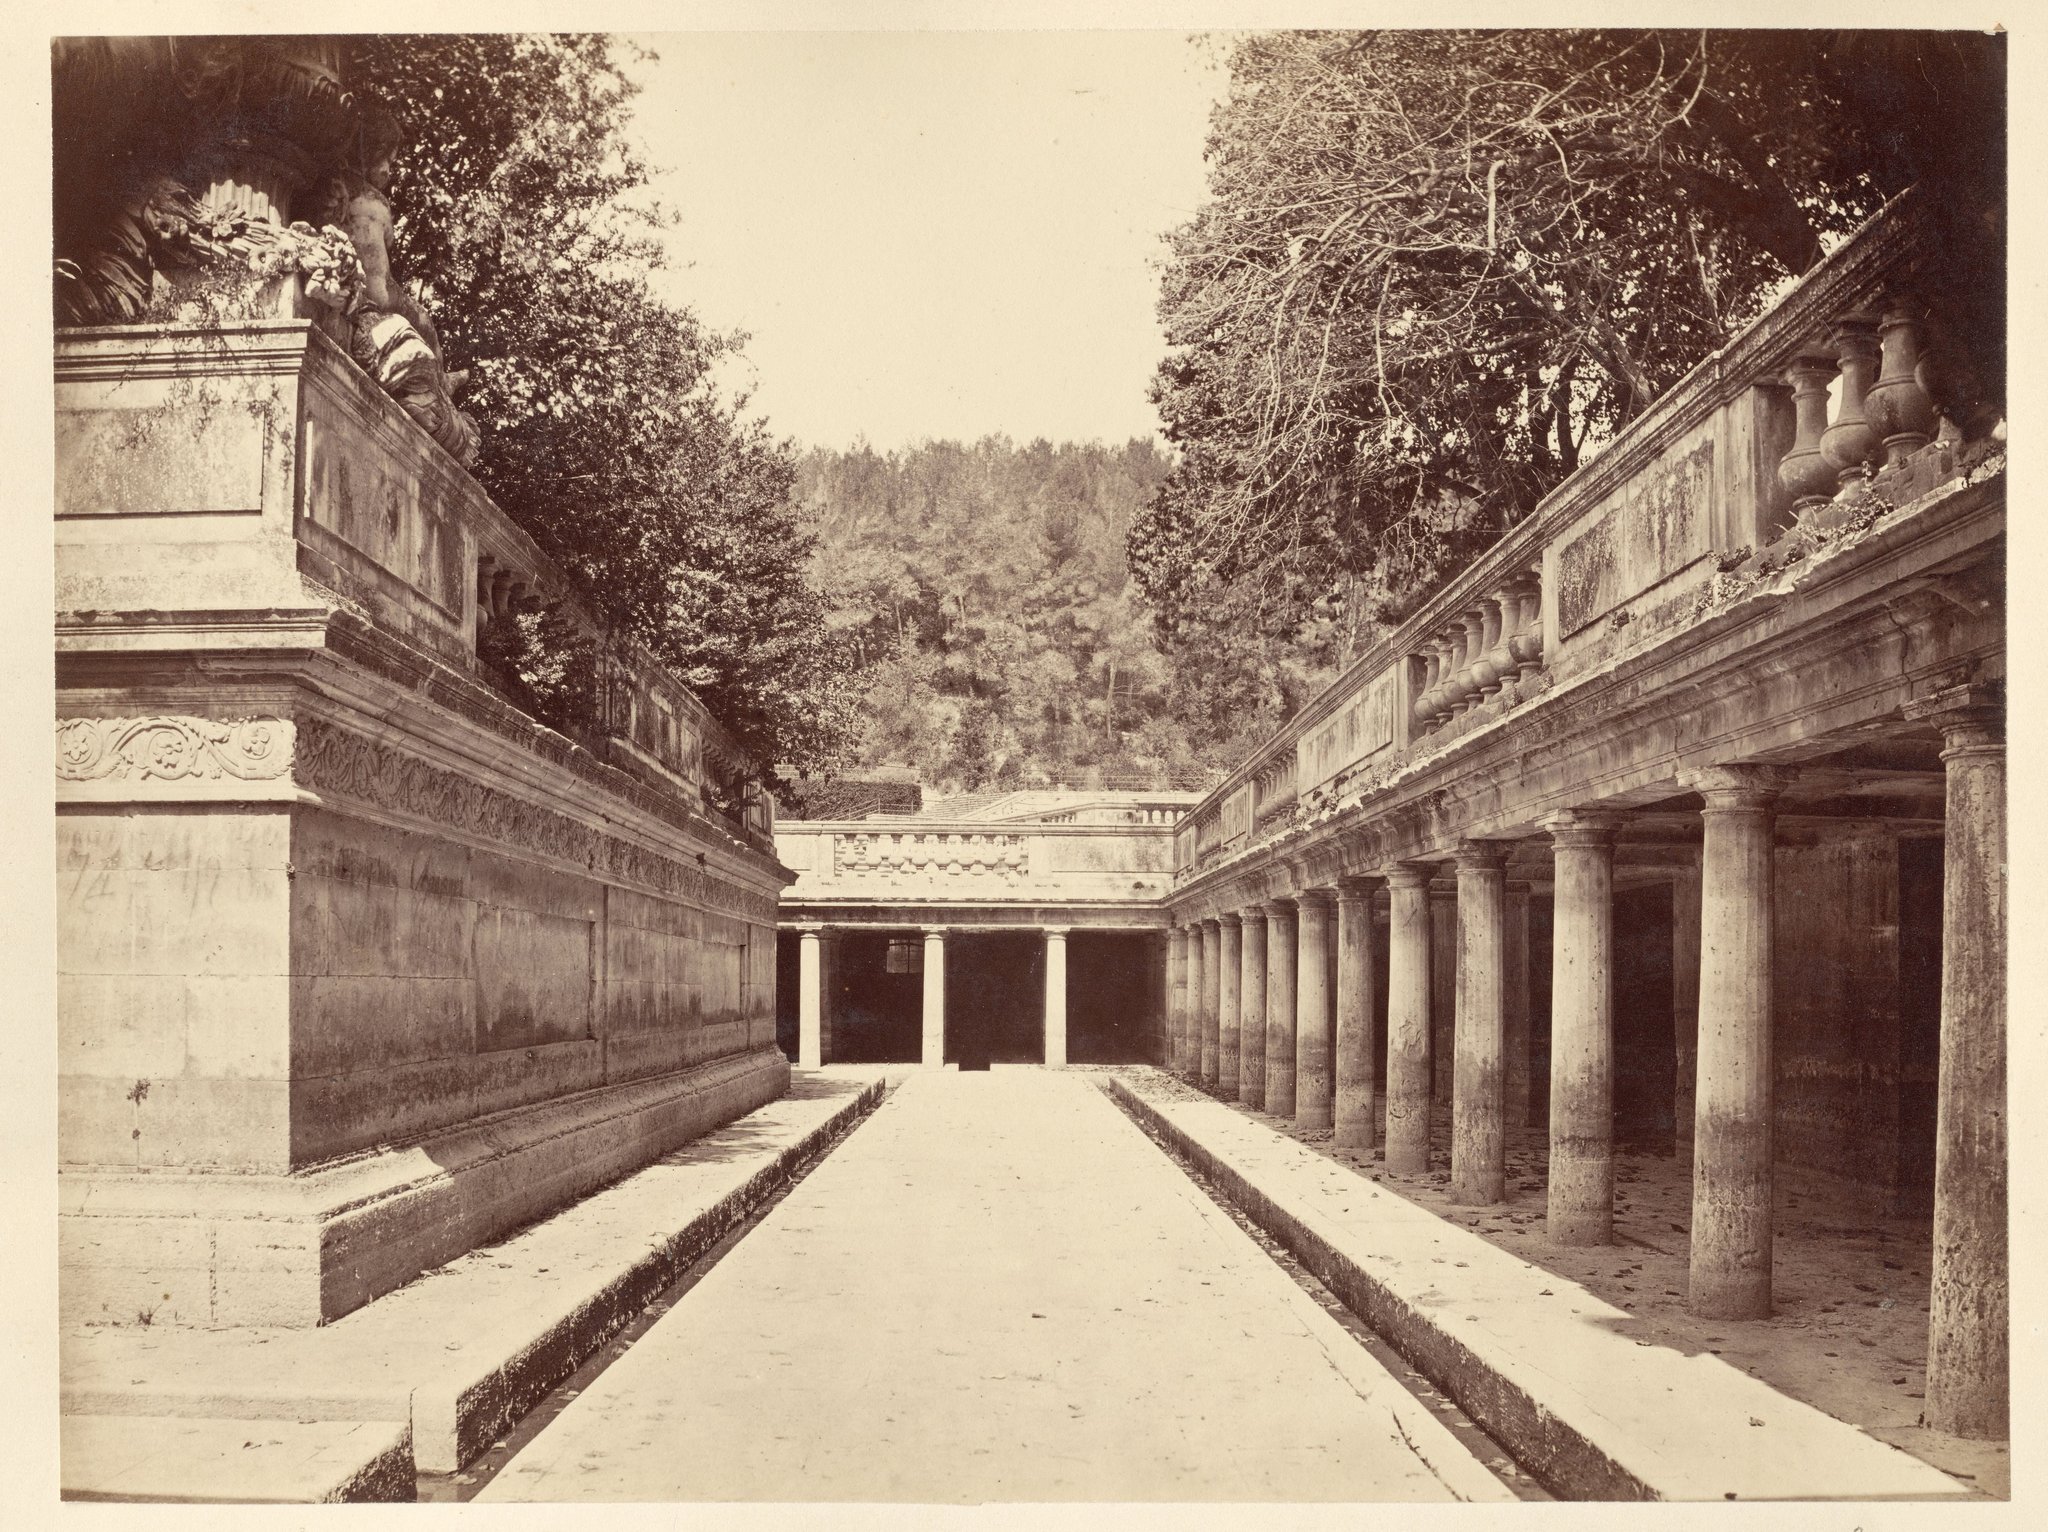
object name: photograph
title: La Nymphée in les Jardins de la Fontaine te Nîmes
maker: louis huguet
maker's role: fotograaf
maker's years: 1840-1877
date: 1866-1877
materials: cardboard, paper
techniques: albumen print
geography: nîmes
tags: colonnade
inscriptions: inscription: ‘Nîmes’